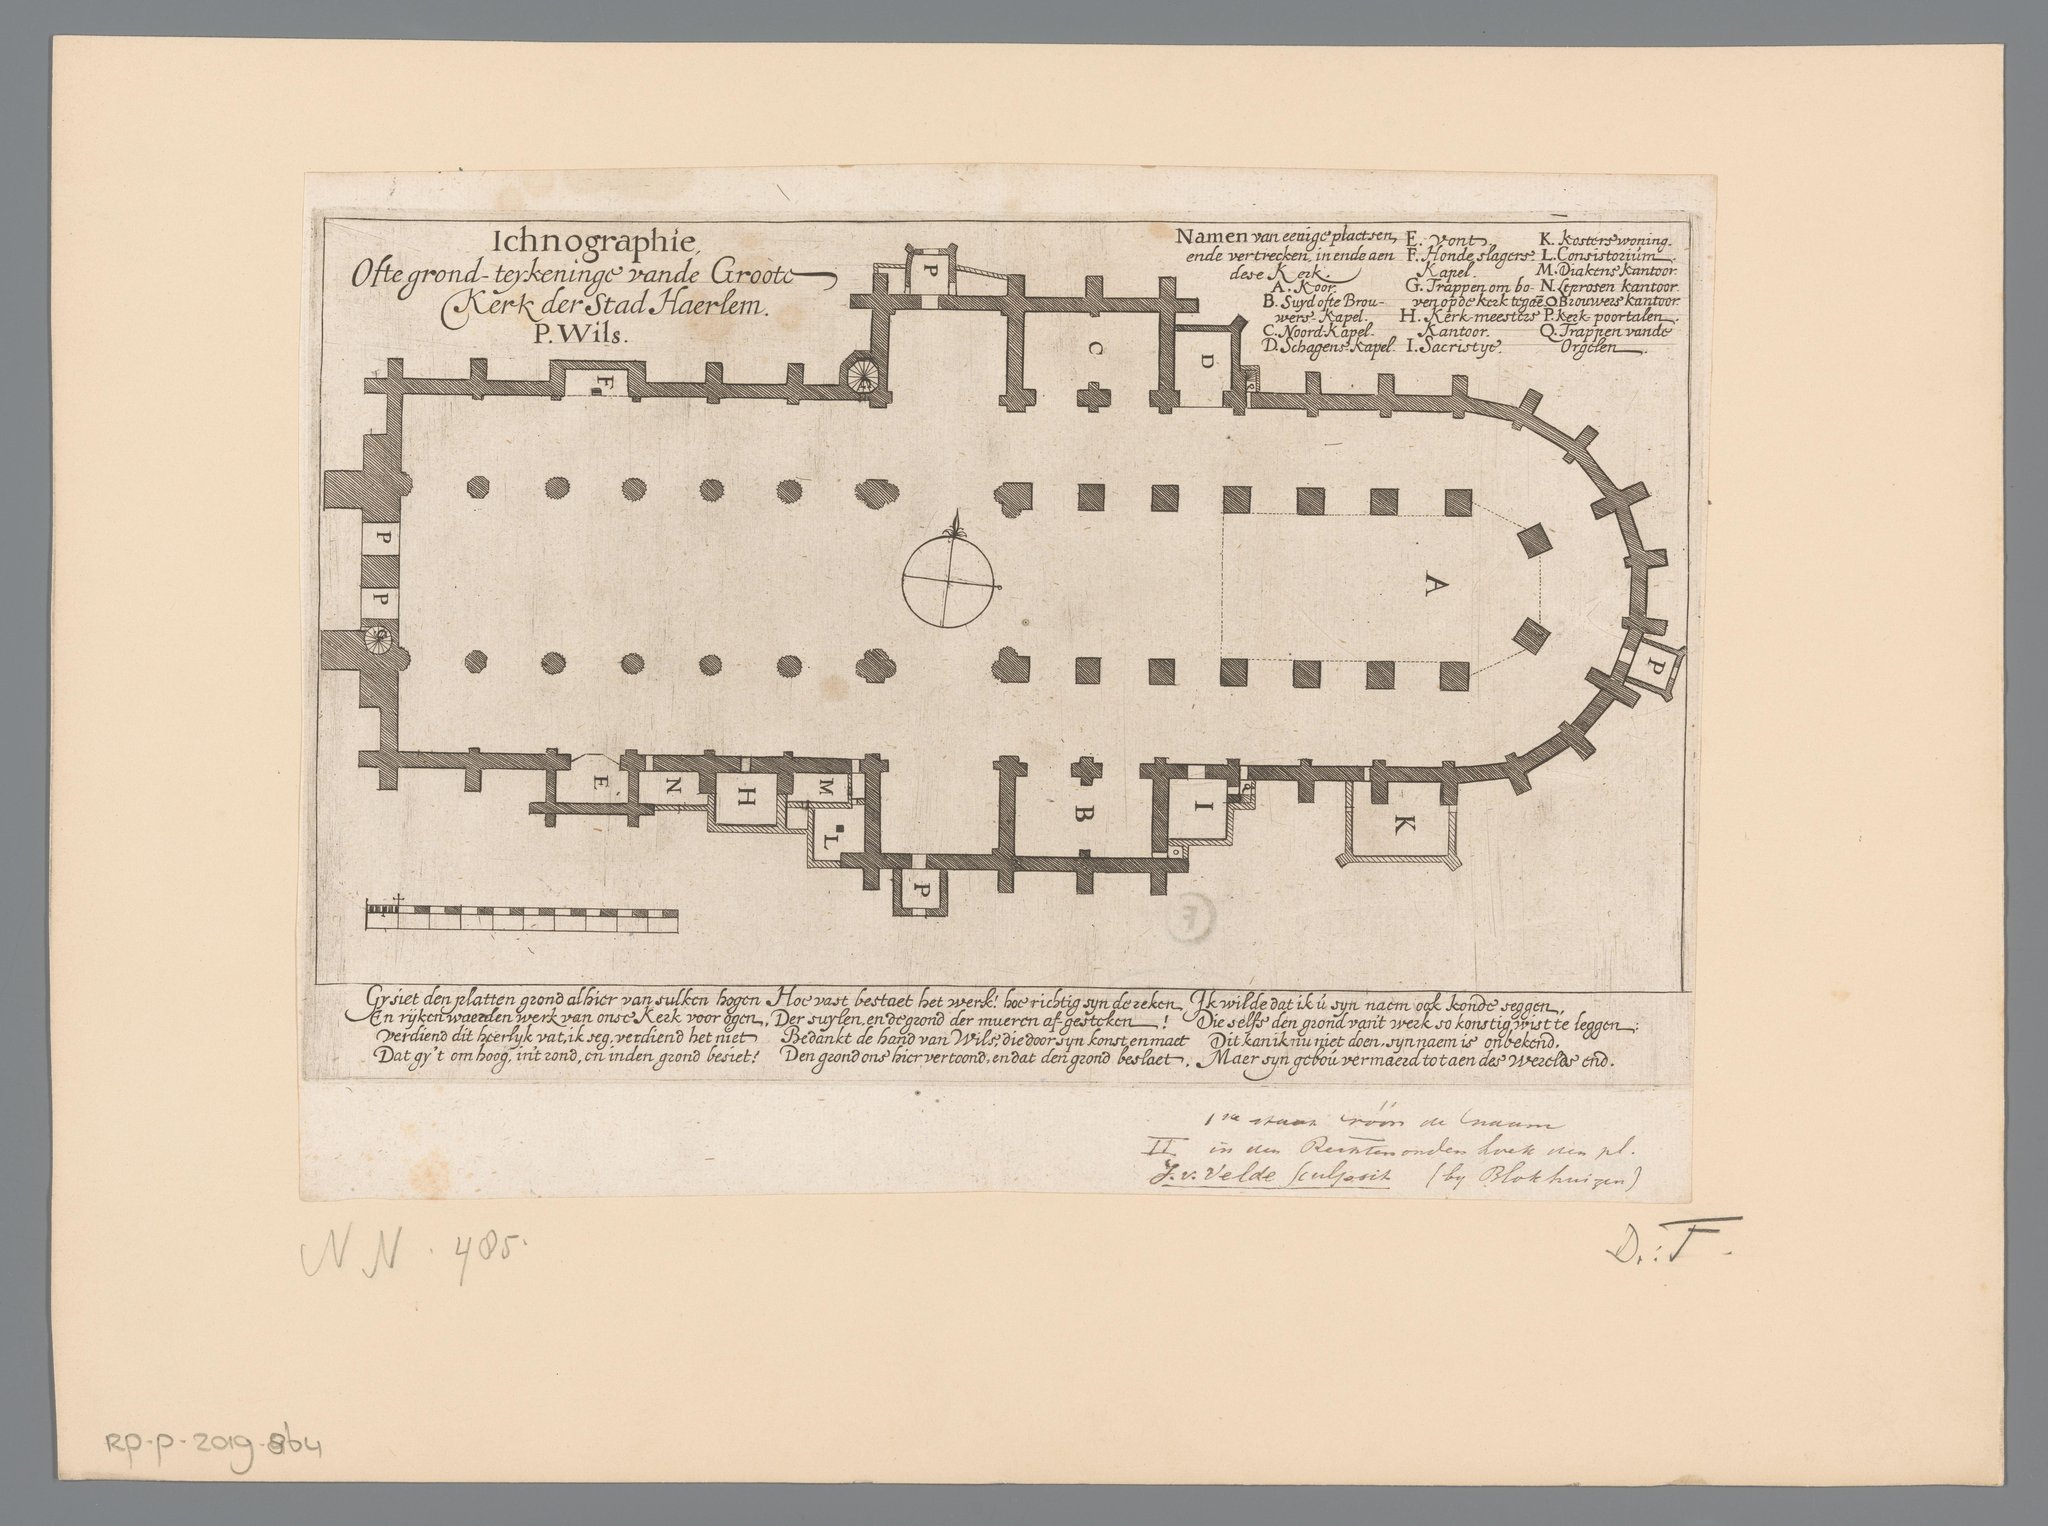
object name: print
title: Plattegrond van de Sint-Bavokerk in Haarlem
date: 1628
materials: paper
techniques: engraving, etching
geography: haarlem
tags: interior of church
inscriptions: collector's mark: Lugt 698, collector's mark: ‘F’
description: Prent uit: Ampzing, Samuel. Beschryvinge ende lof der stad Haerlem in Holland (…). Haarlem: Adriaen Roman (I), 1628, p. 502-503.